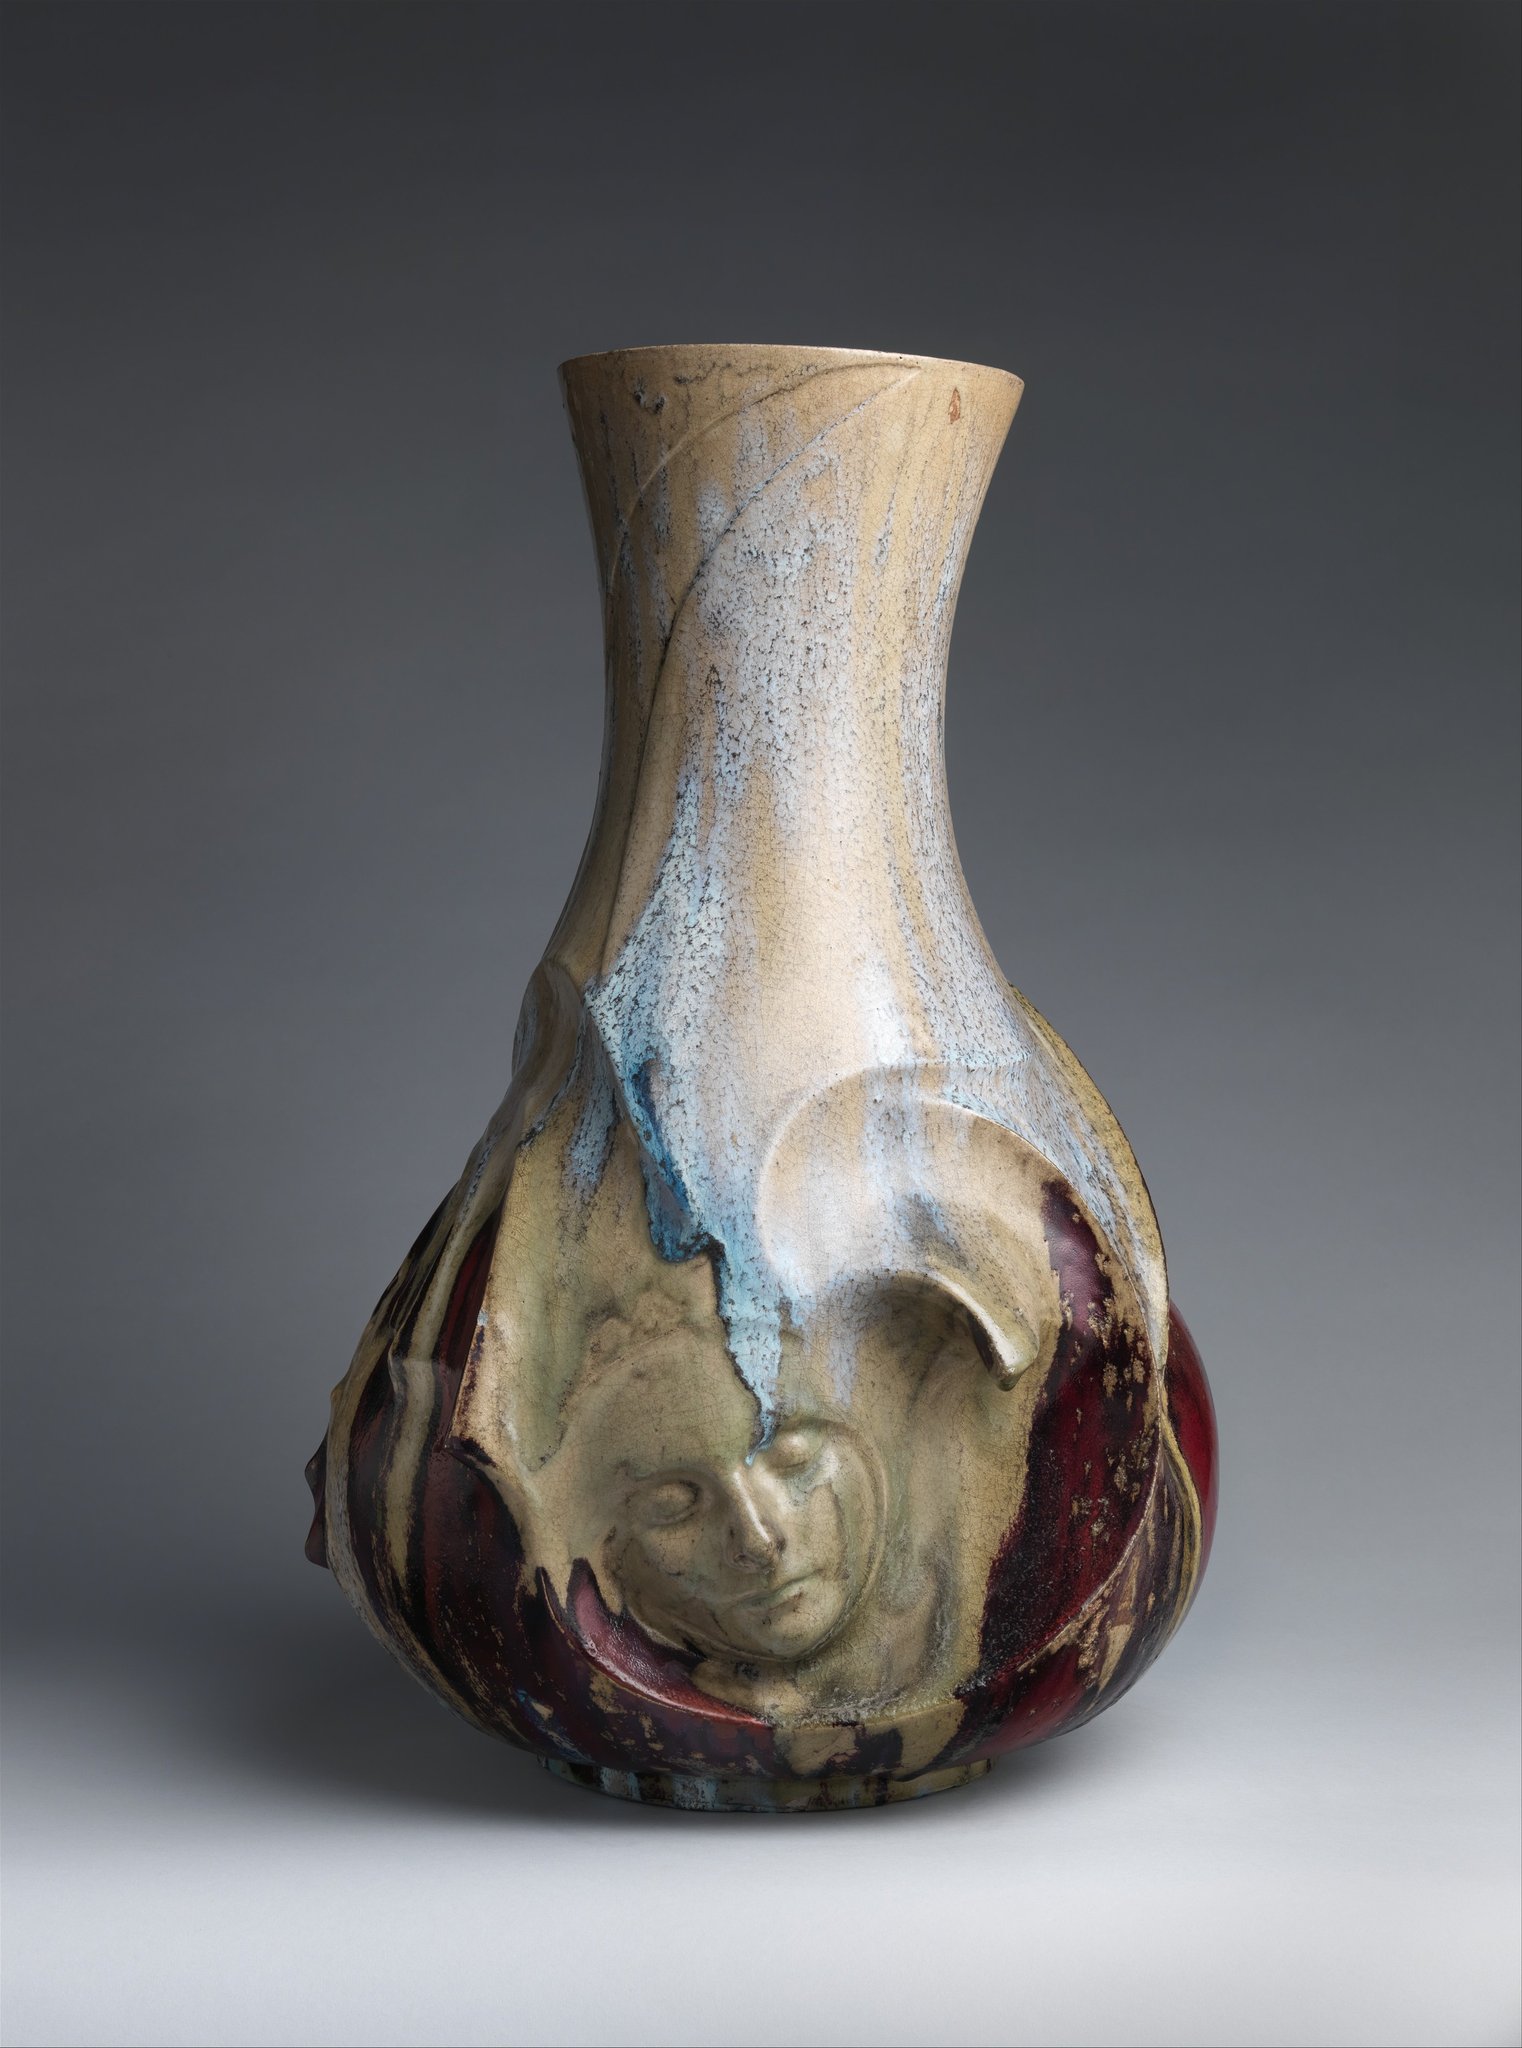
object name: vase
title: Vase with face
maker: pierre-adrien dalpayrat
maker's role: maker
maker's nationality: french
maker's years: 1844-1910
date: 1892-1893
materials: stoneware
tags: faces,women